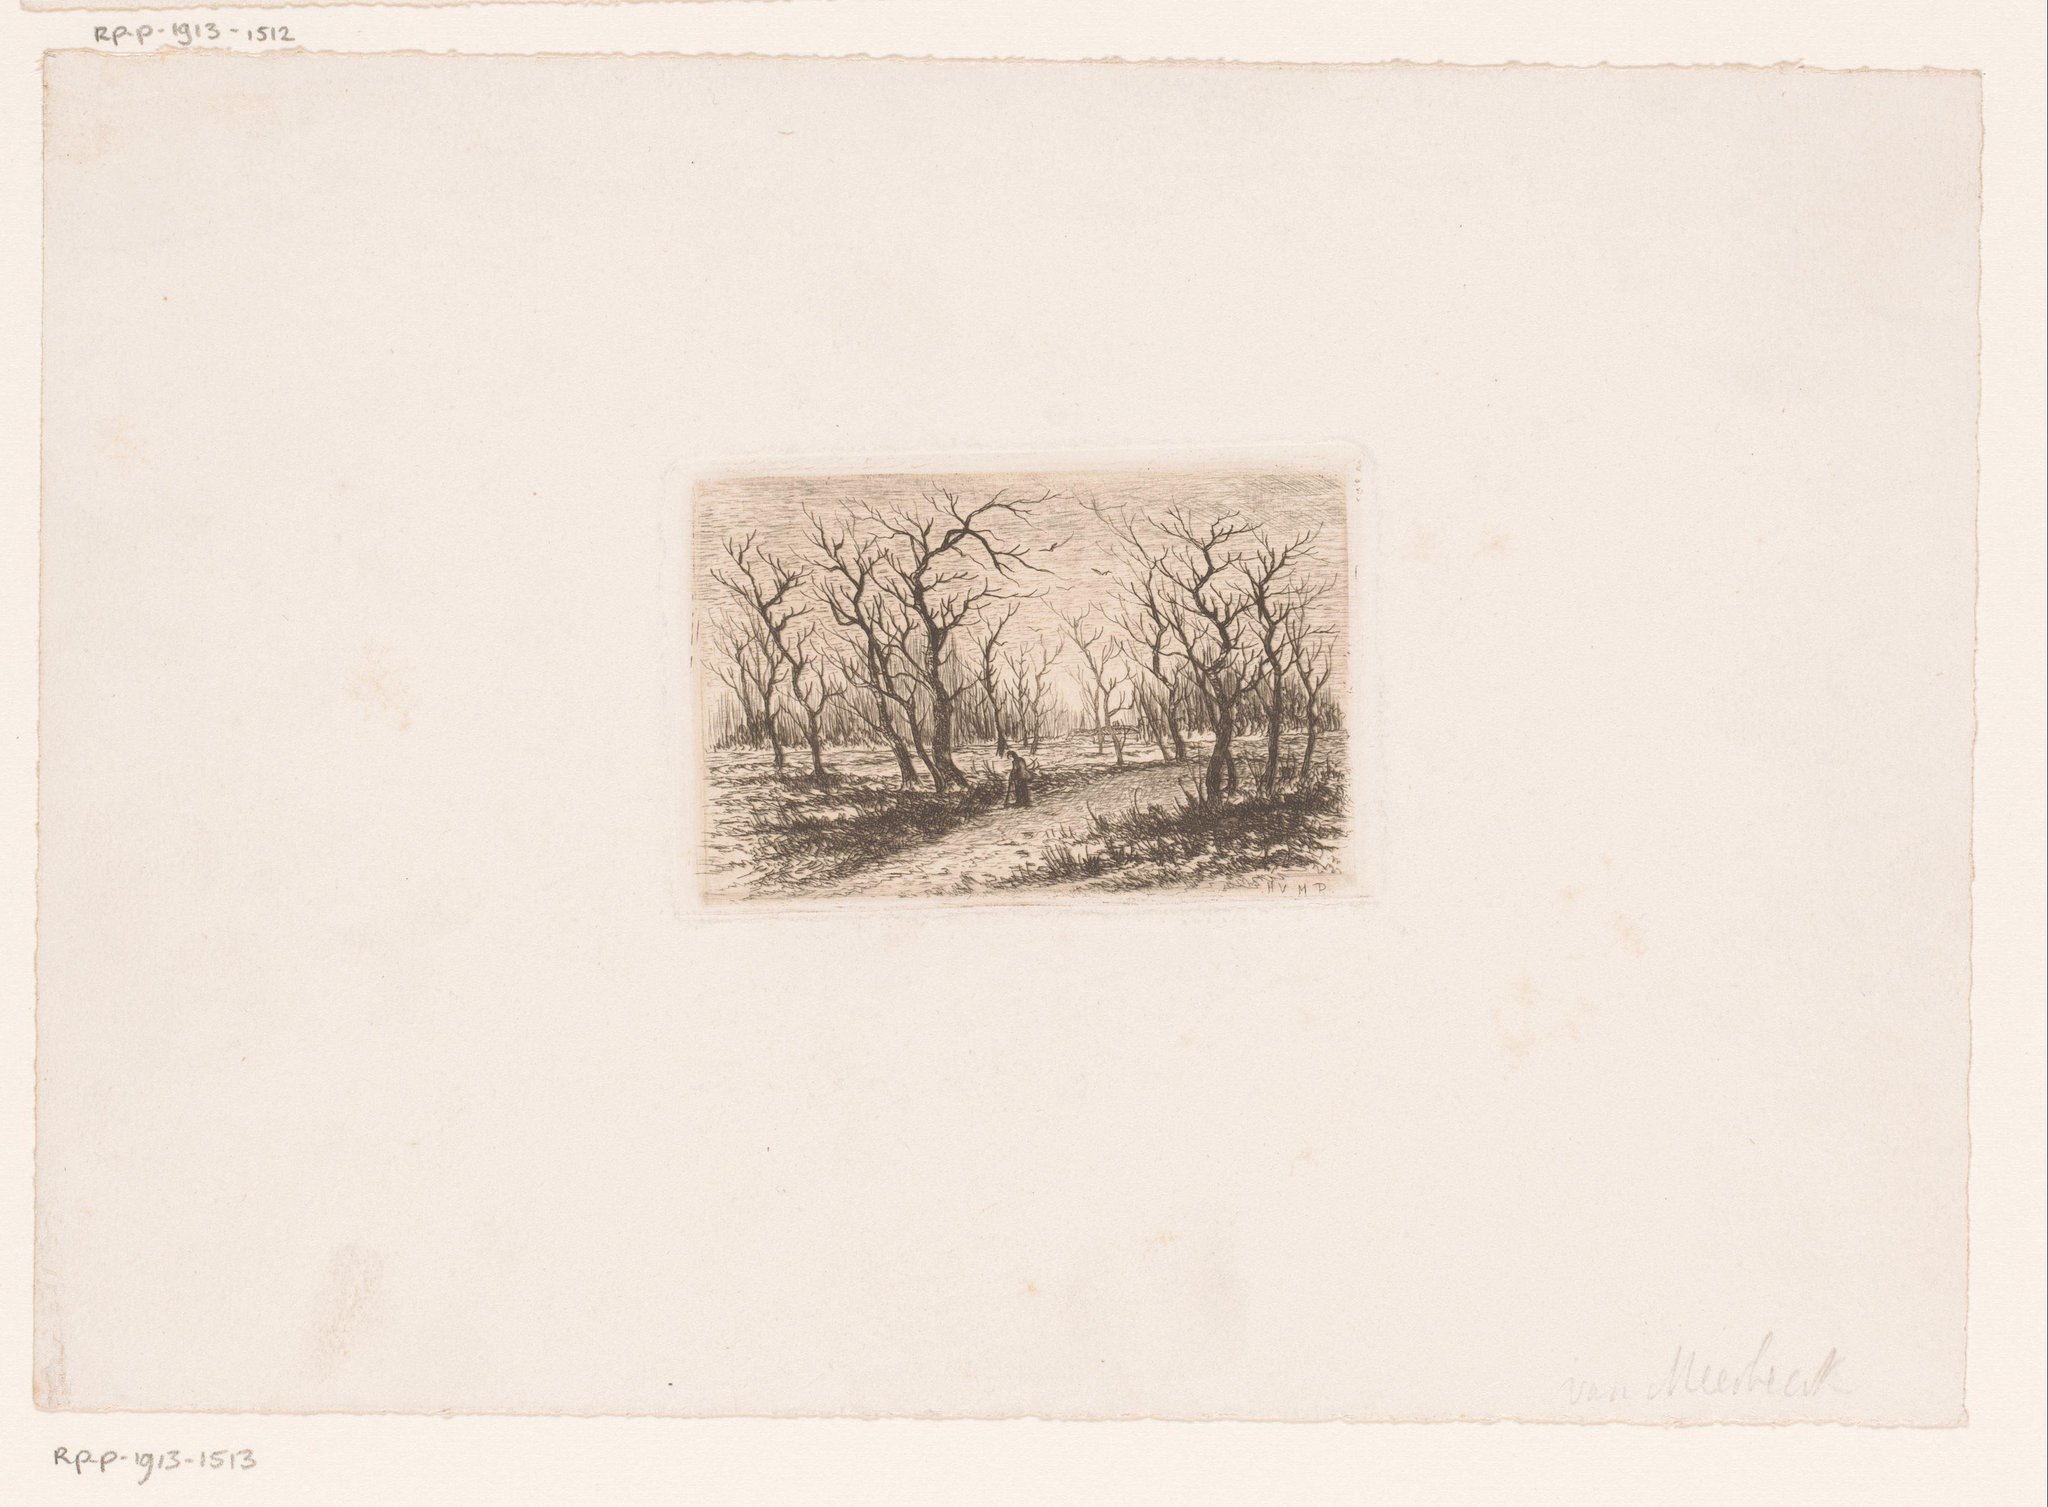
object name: print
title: Landschap met kale bomen en een figuur met wandelstok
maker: h. van meerbeeck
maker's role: print maker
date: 1850-1913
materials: paper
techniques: etching, intaglio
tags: walking-stick, staff, landscapes (+ landscape with figures, staffage)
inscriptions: collector's mark: Lugt 2228